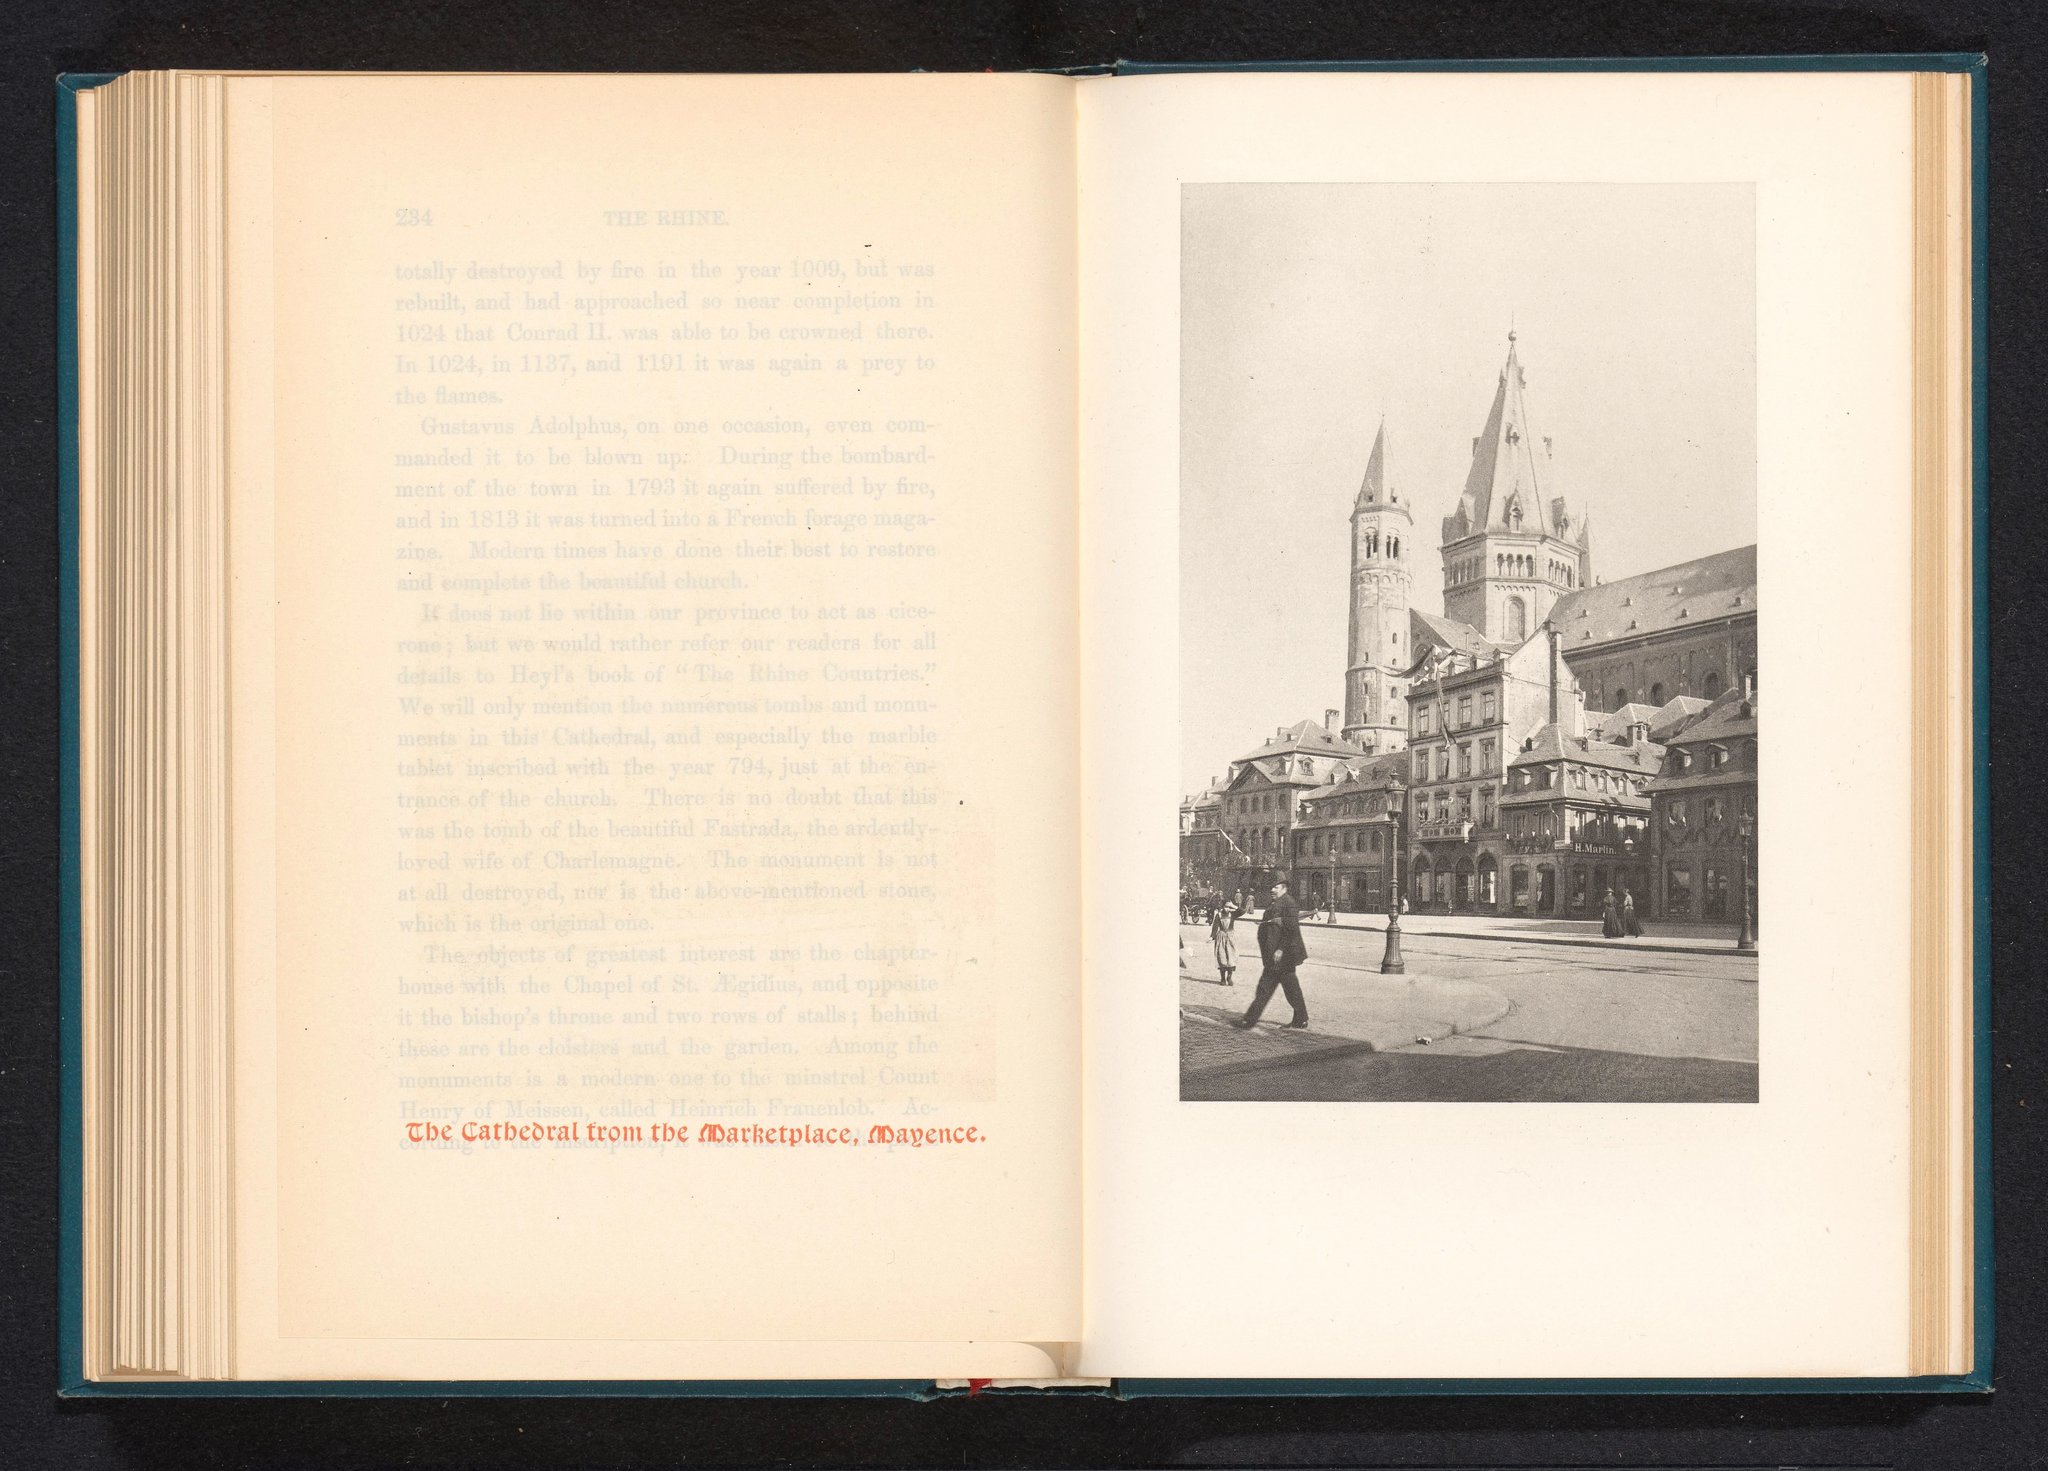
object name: photomechanical print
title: Gezicht op de Dom van Mainz vanaf de Markt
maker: Anonymous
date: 1889-1899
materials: paper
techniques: photoaquatint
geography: markt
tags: square, place, circus, etc., market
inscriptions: title: ‘The Cathedral from the Marketplace, Mayence.’